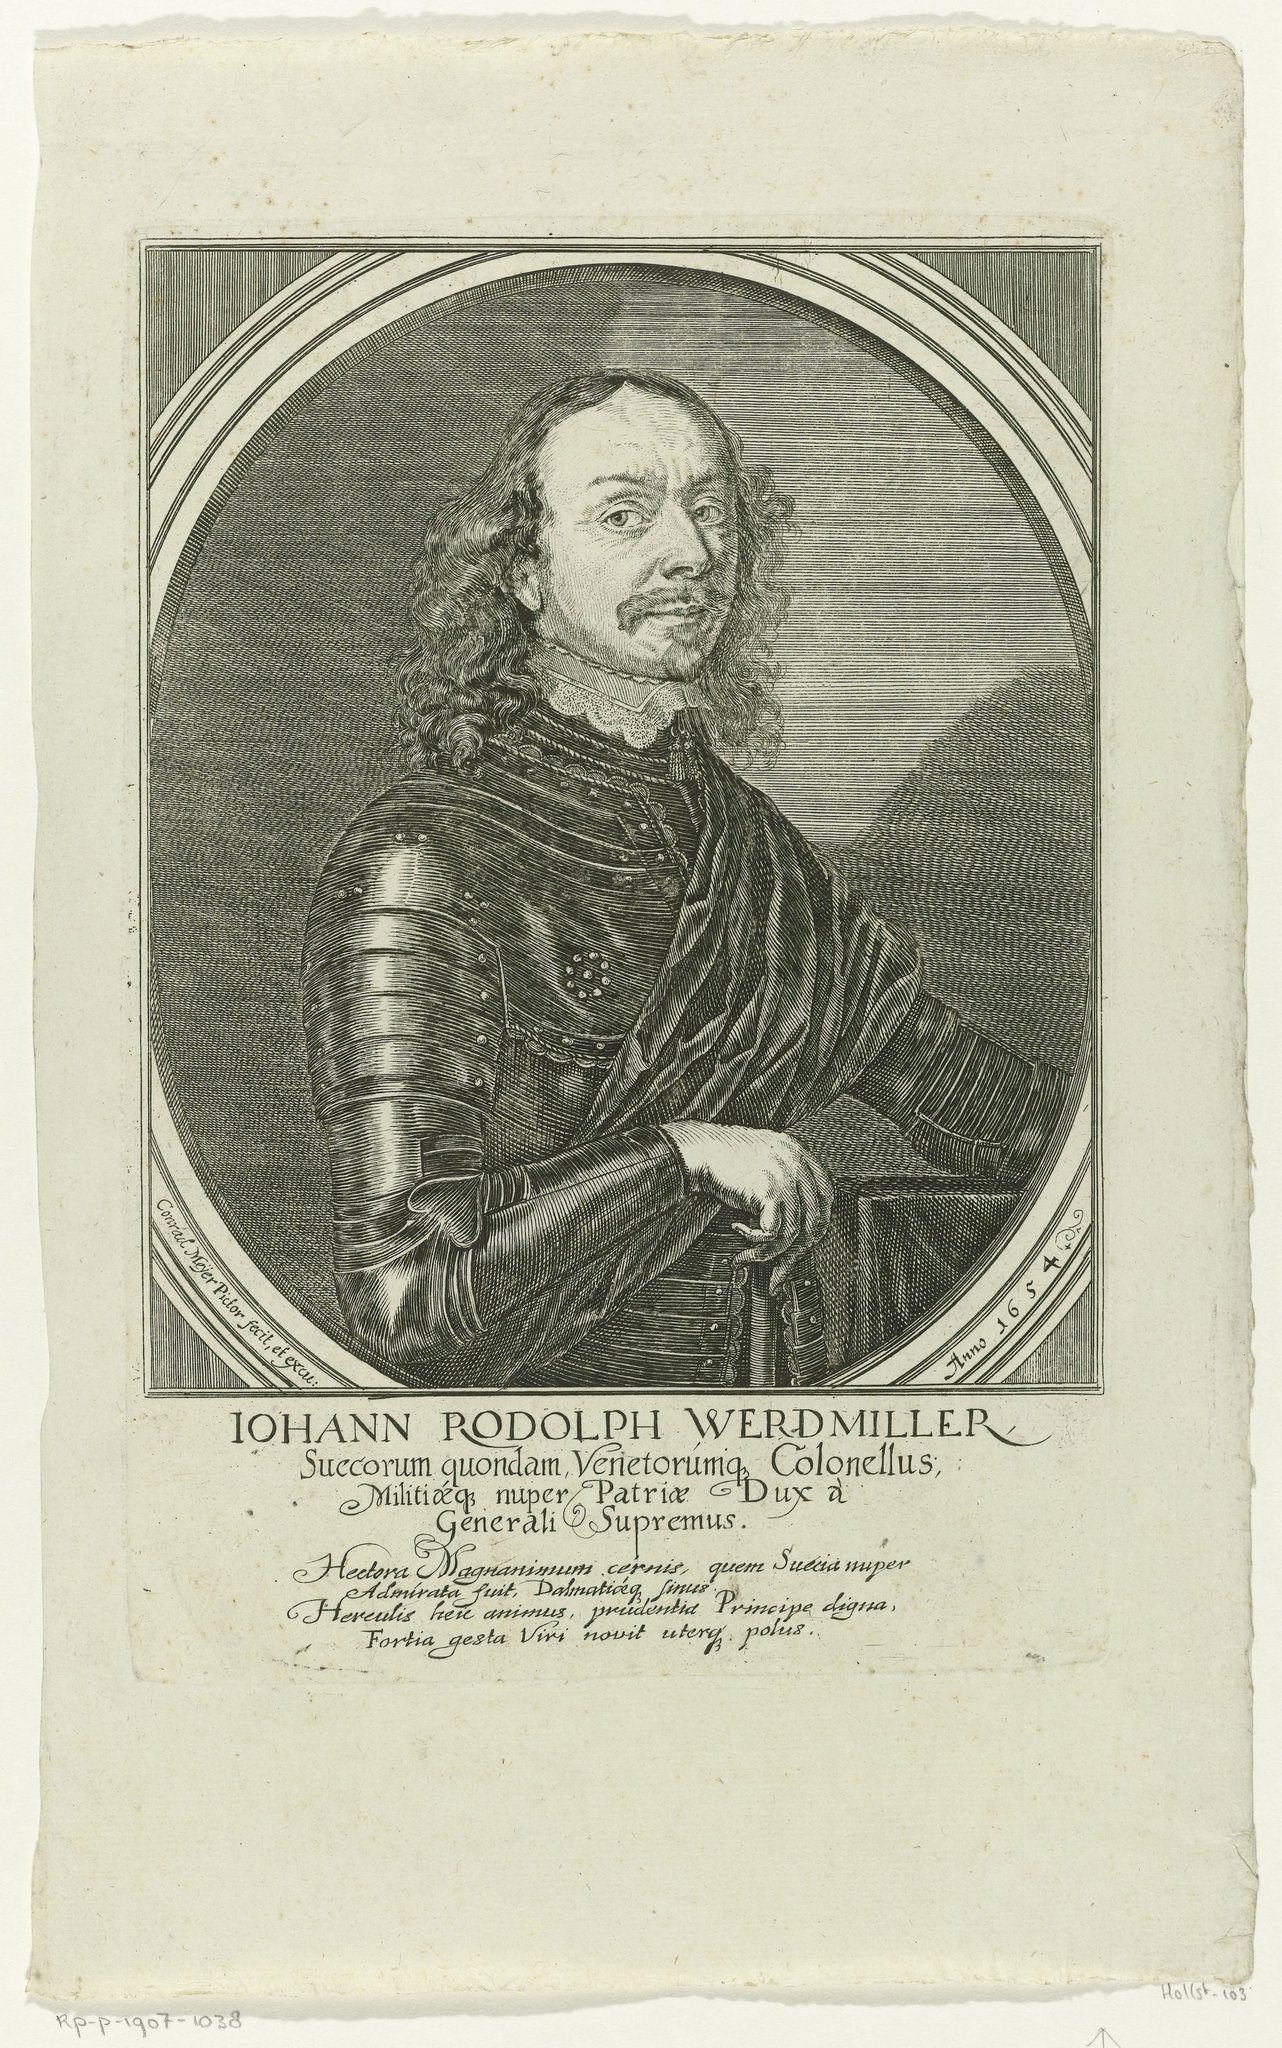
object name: print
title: Portret van Johann Rudolf Werdmüller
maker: conrad meyer (i)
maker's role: painter, print maker, publisher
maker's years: 1618-1689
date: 1654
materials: paper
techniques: engraving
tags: armour, historical persons, baton of general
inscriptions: collector's mark: Lugt 2228